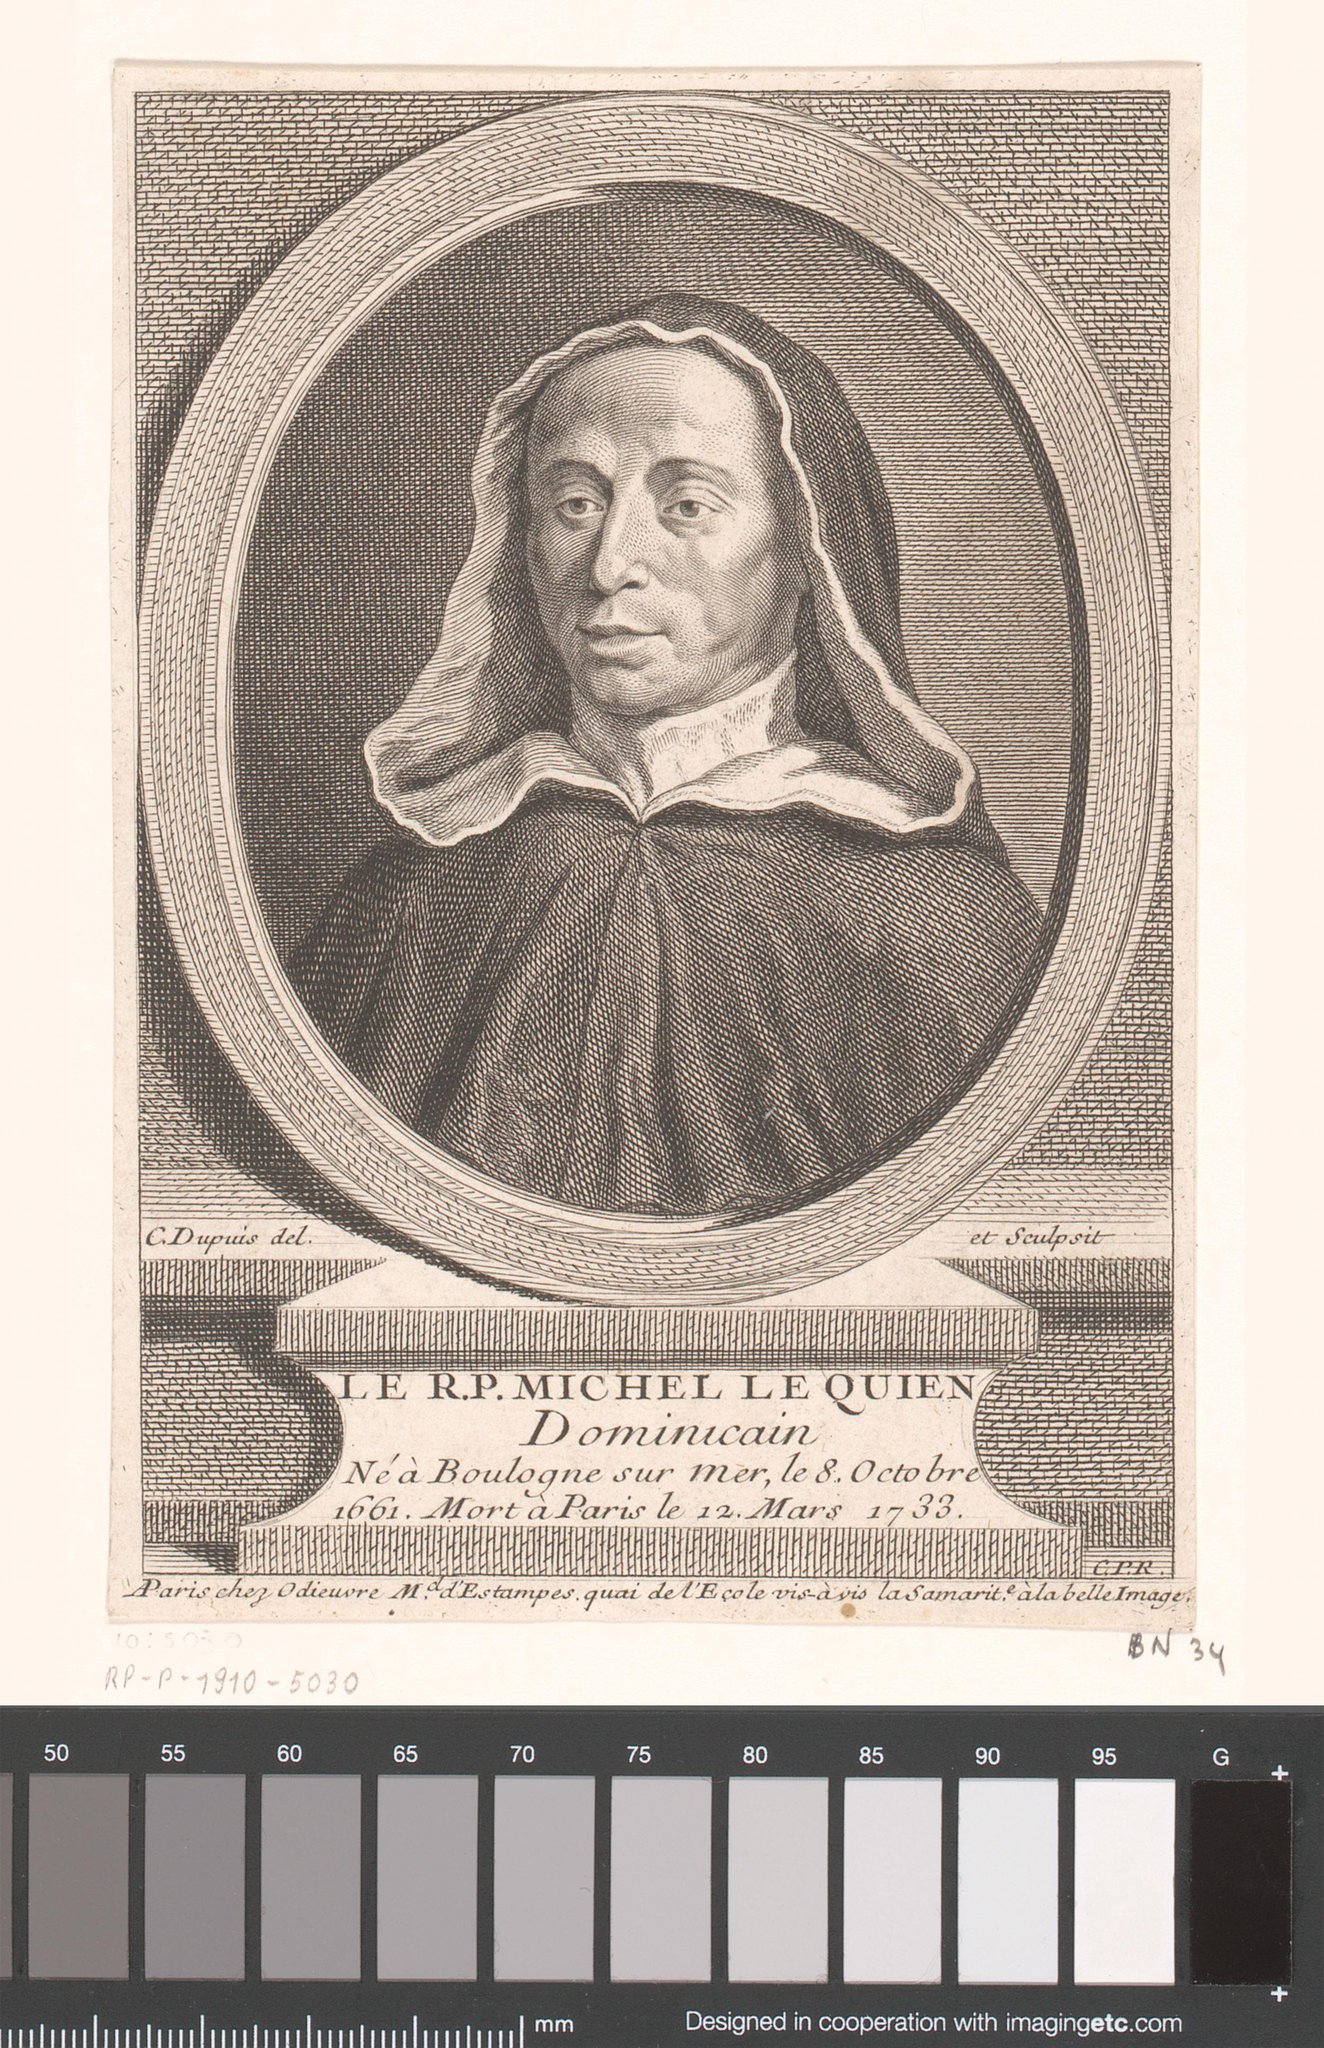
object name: book illustration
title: Portret van Michel Le Quien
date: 1739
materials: paper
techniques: engraving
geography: paris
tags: paris, theologian, historical persons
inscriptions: collector's mark: Lugt 2228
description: Prent uit: Dreux du Radier, Jean-François. L'Europe illustré, contenant l'histoire abregée des souverains, des princes, des prélats, des ministres, (...) en Europe: dans le XVe. siècle compris, jusqu'à présent. Parijs: Michel Odieuvre en Jean-Luc Nyon, ca. 1739, dl. 3.